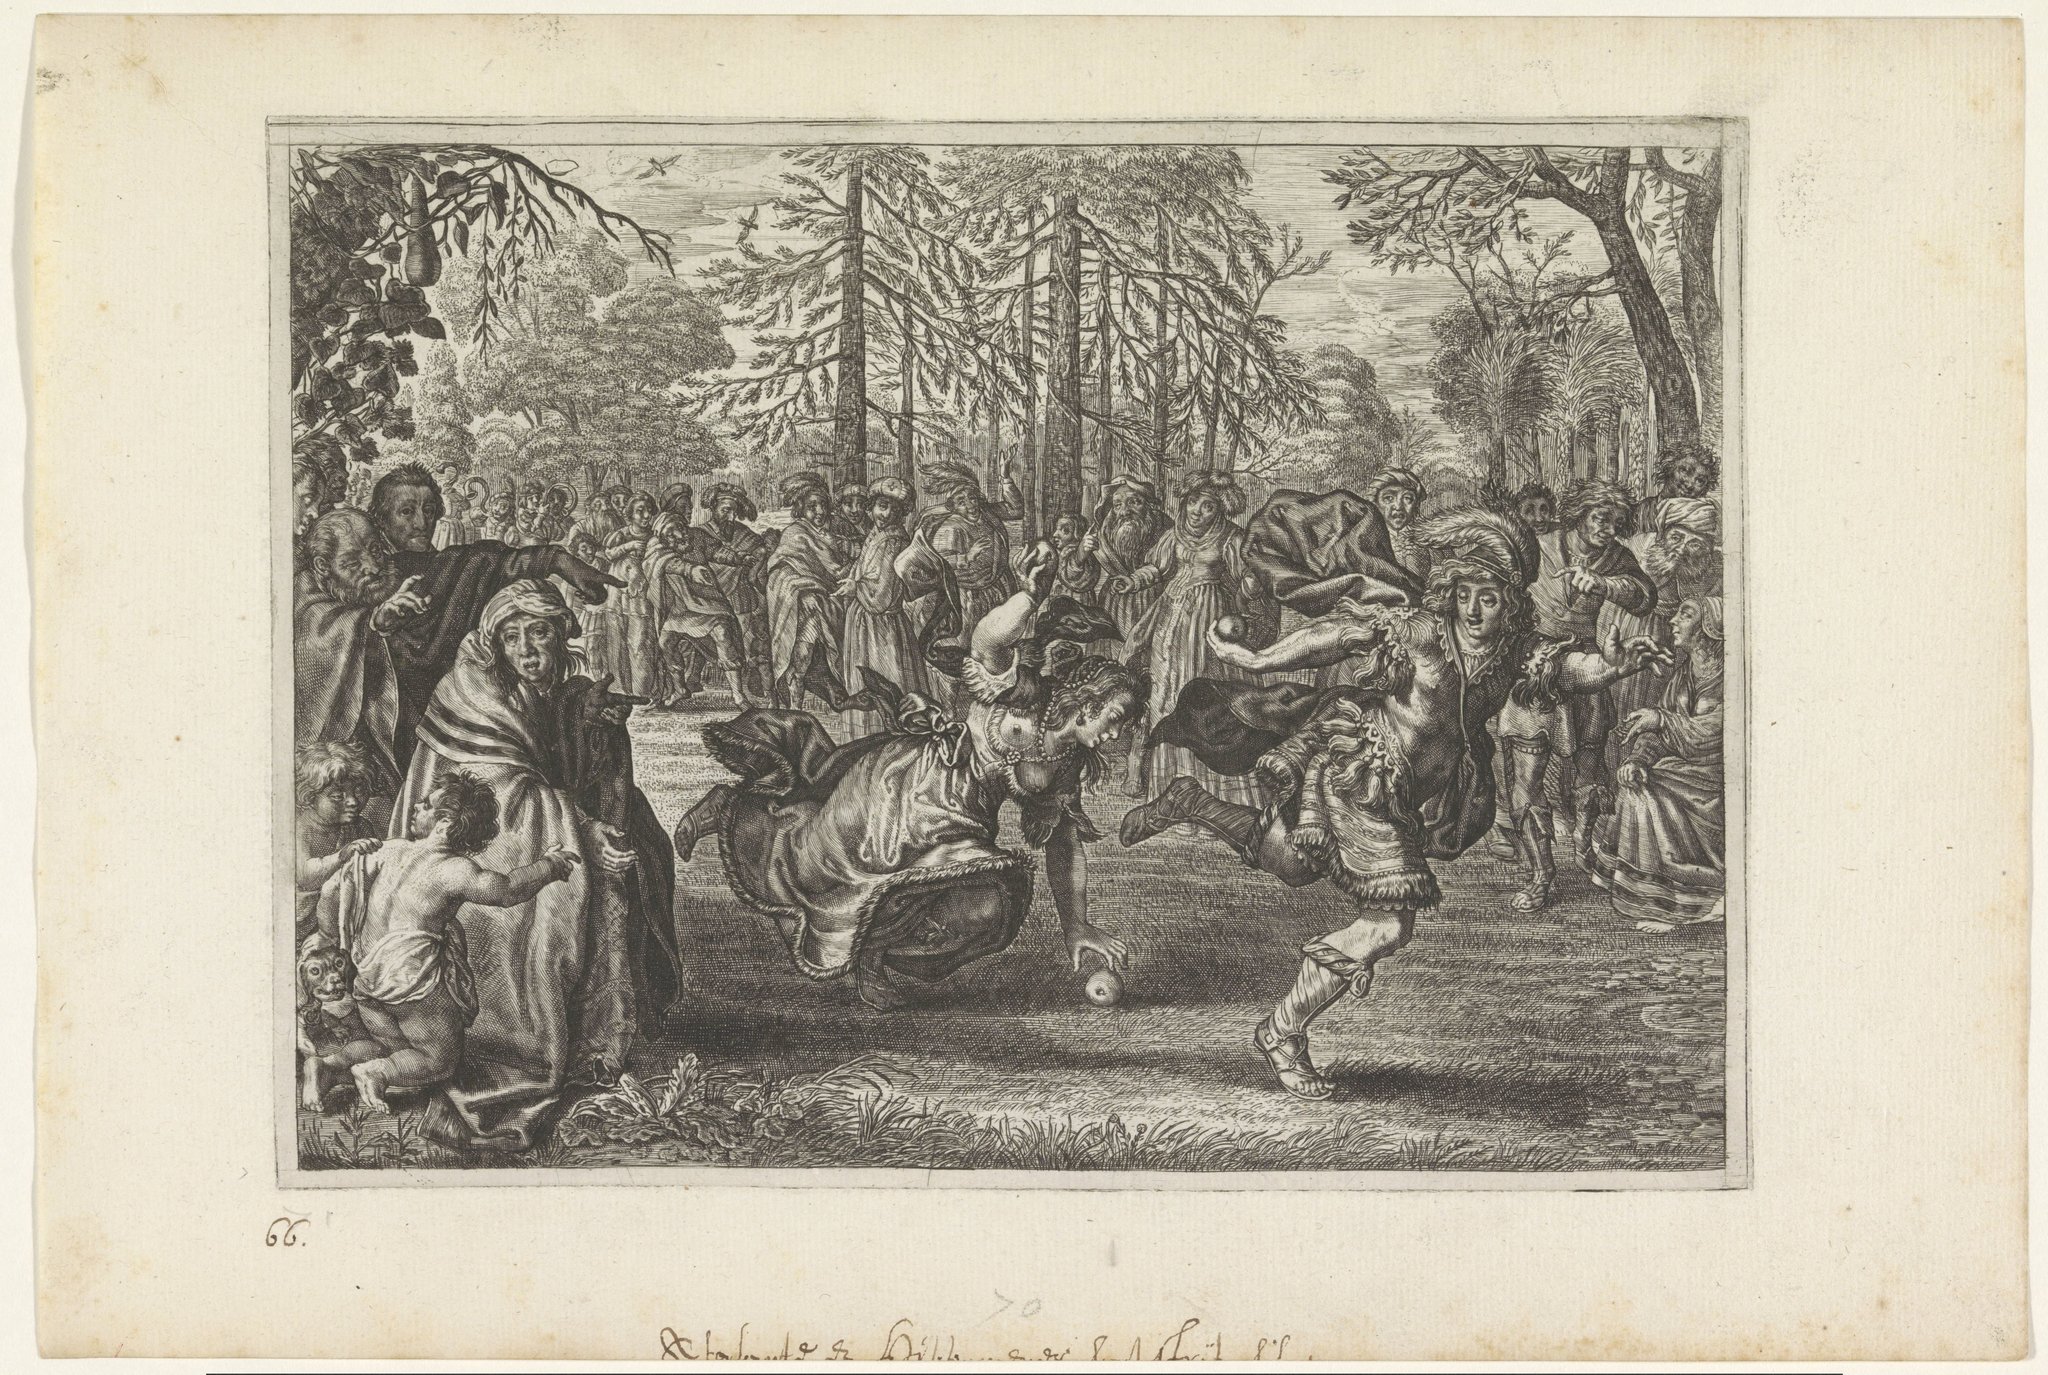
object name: print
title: Atalanta en Hippomenes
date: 1636-1670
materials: paper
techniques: engraving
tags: during the foot-race hippomenes drops the three golden apples; atalante stops to pick them up, and is thus beaten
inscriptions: number: ‘66’, collector's mark: ‘Hinloopen’, annotation: ‘Atalante en Hippomenes [...] strijt lib [...]’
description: Deze incomplete serie, bestaande uit 77 van de in totaal 85 prenten met scènes uit Ovidius' Metamorfosen, werd in 1709 samen met Ovidius-illustraties van Tempesta, Goltzius en Le Pautre in één album, Schijnvoet nummer 43, ingebonden. In de negentiende eeuw werd deze band weer uit elkaar gehaald.